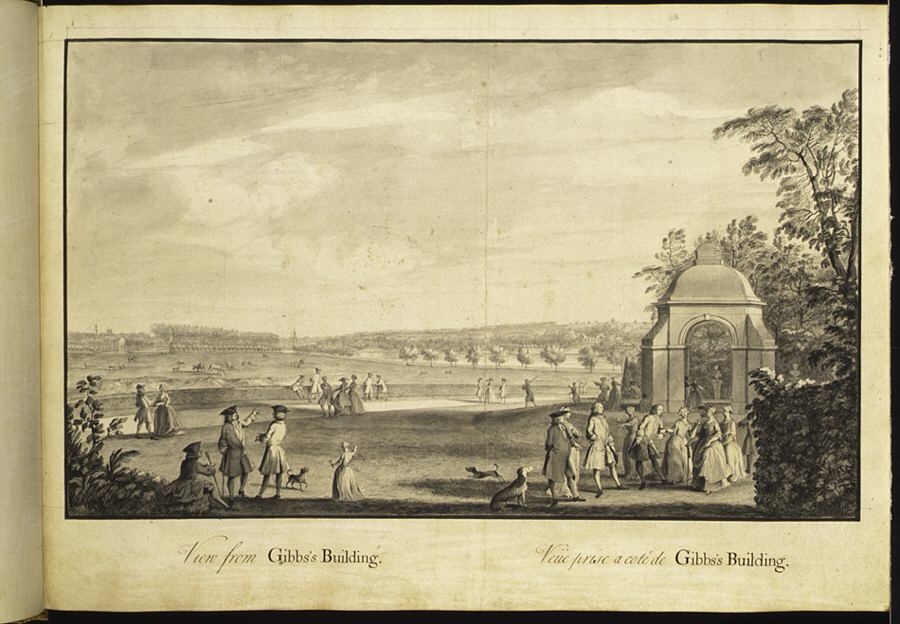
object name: drawing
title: View from Gibbs's Building at Stowe, Buckinghamshire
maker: jacques rigaud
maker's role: artist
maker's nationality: french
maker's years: 1681-1754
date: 1733-1734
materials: ink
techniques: brush, pen, wash